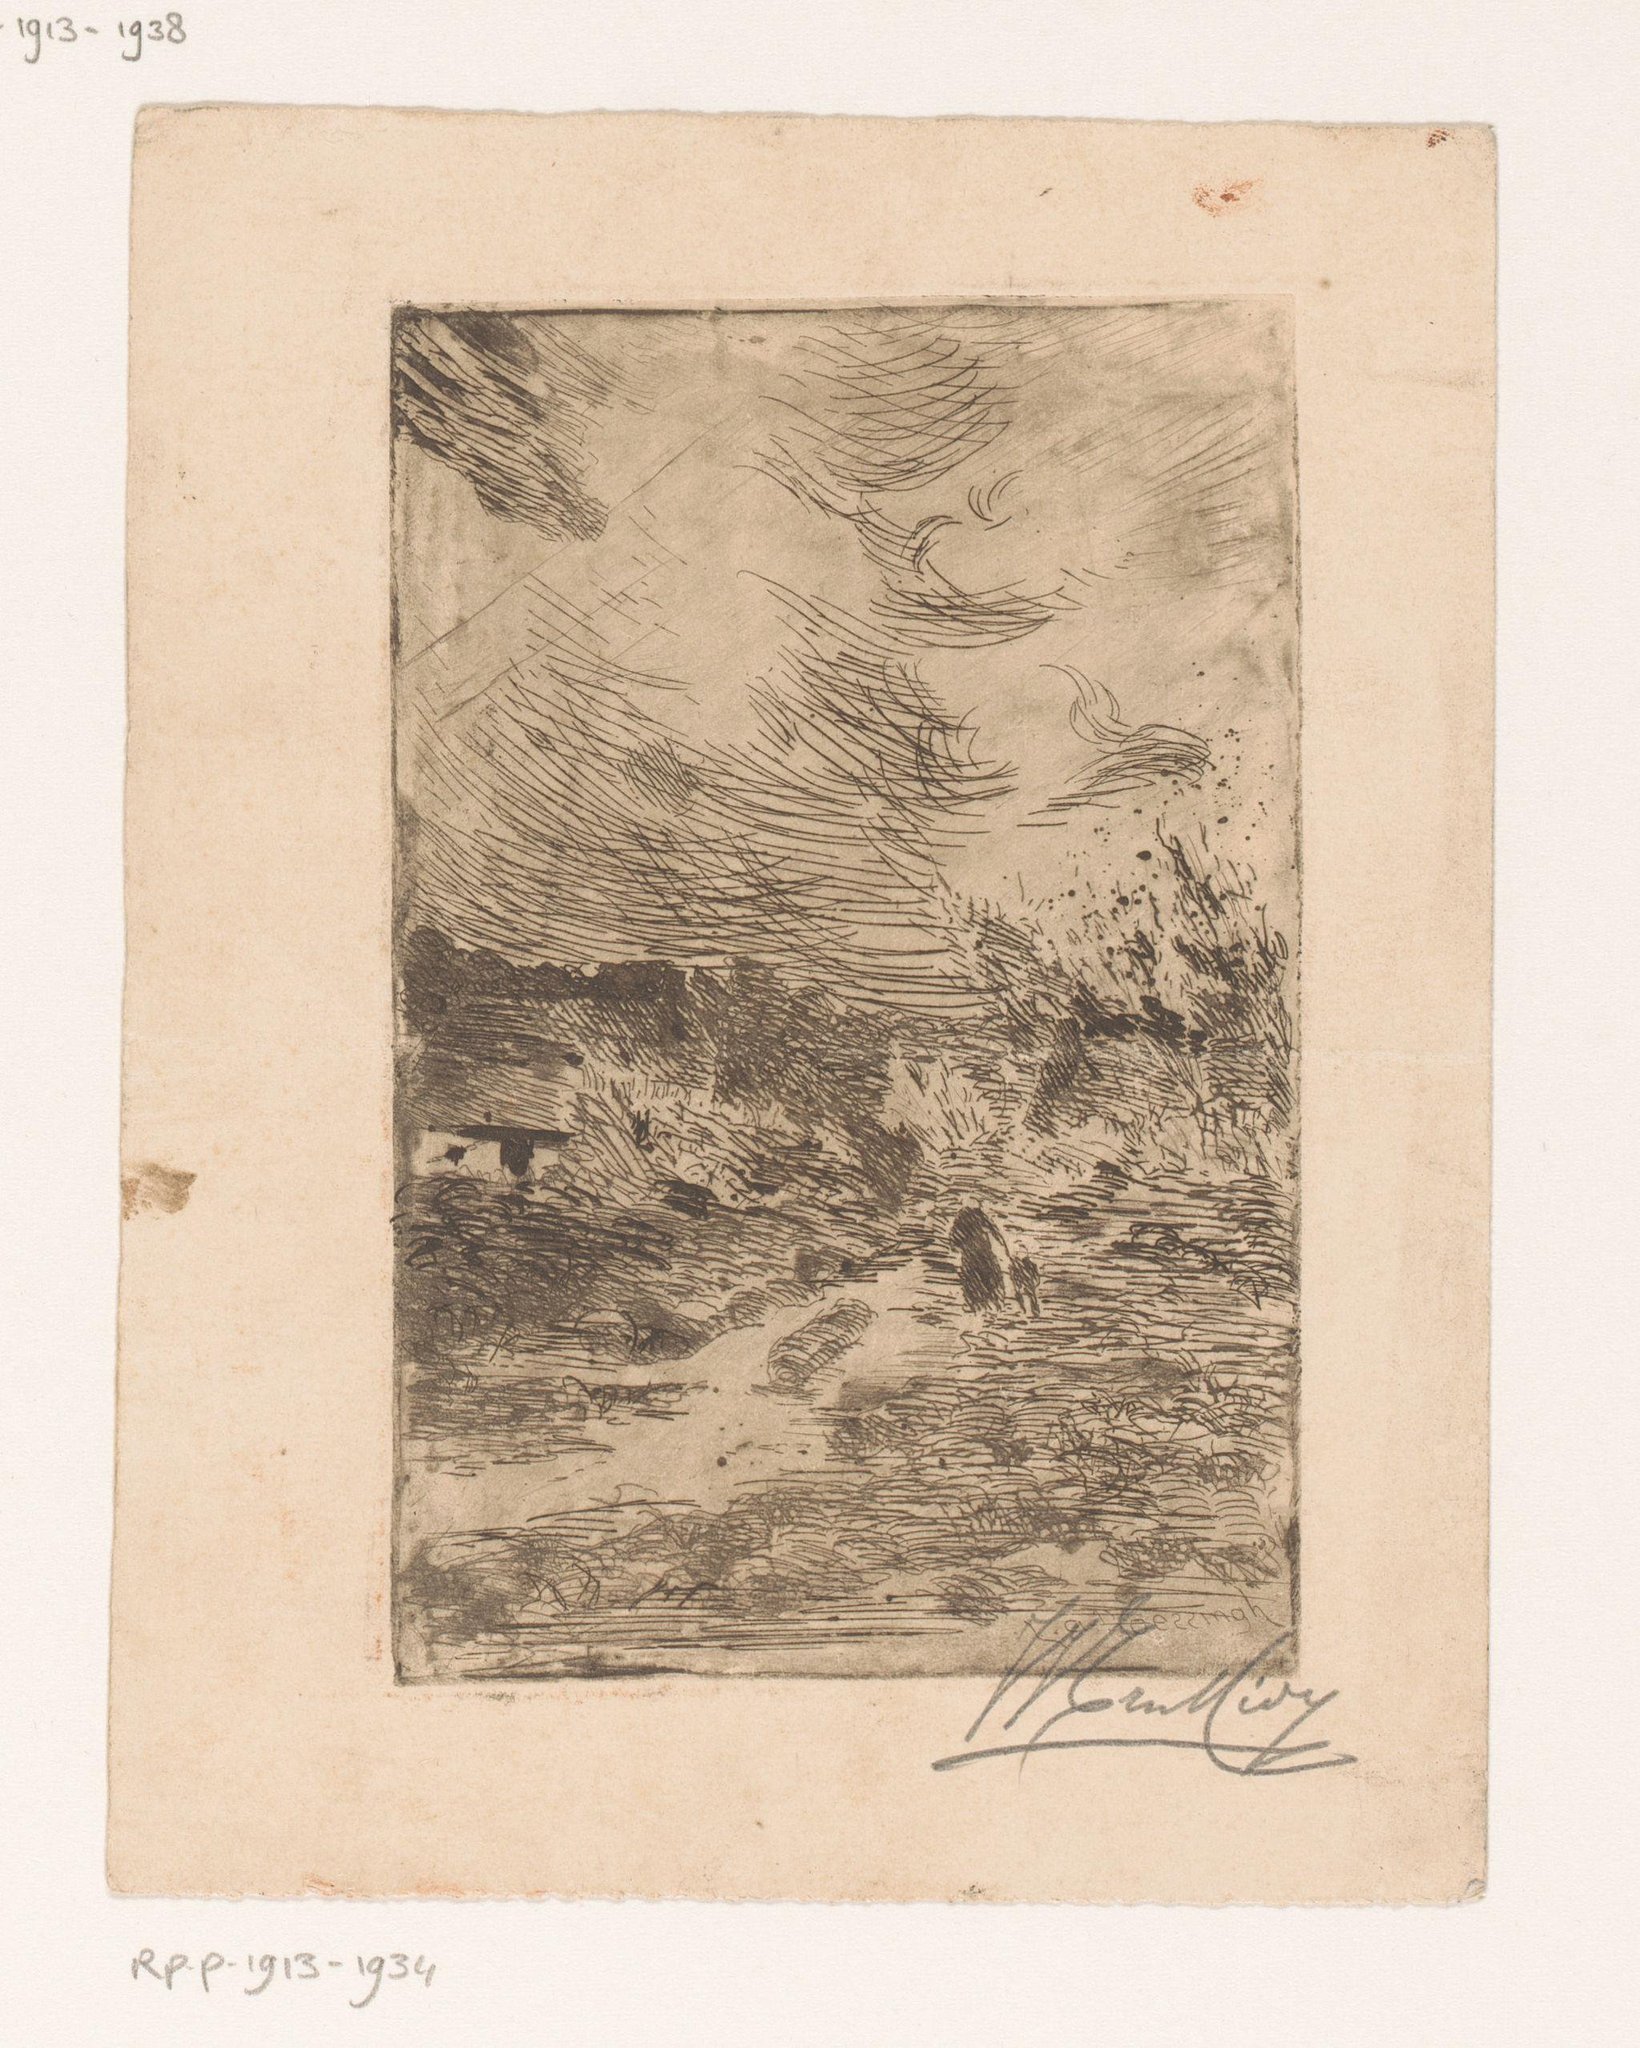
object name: print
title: Landschap met figuur en kind lopend door een storm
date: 1896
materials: paper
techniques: etching, intaglio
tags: storm, landscapes (+ landscape with figures, staffage)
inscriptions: collector's mark: Lugt 2228